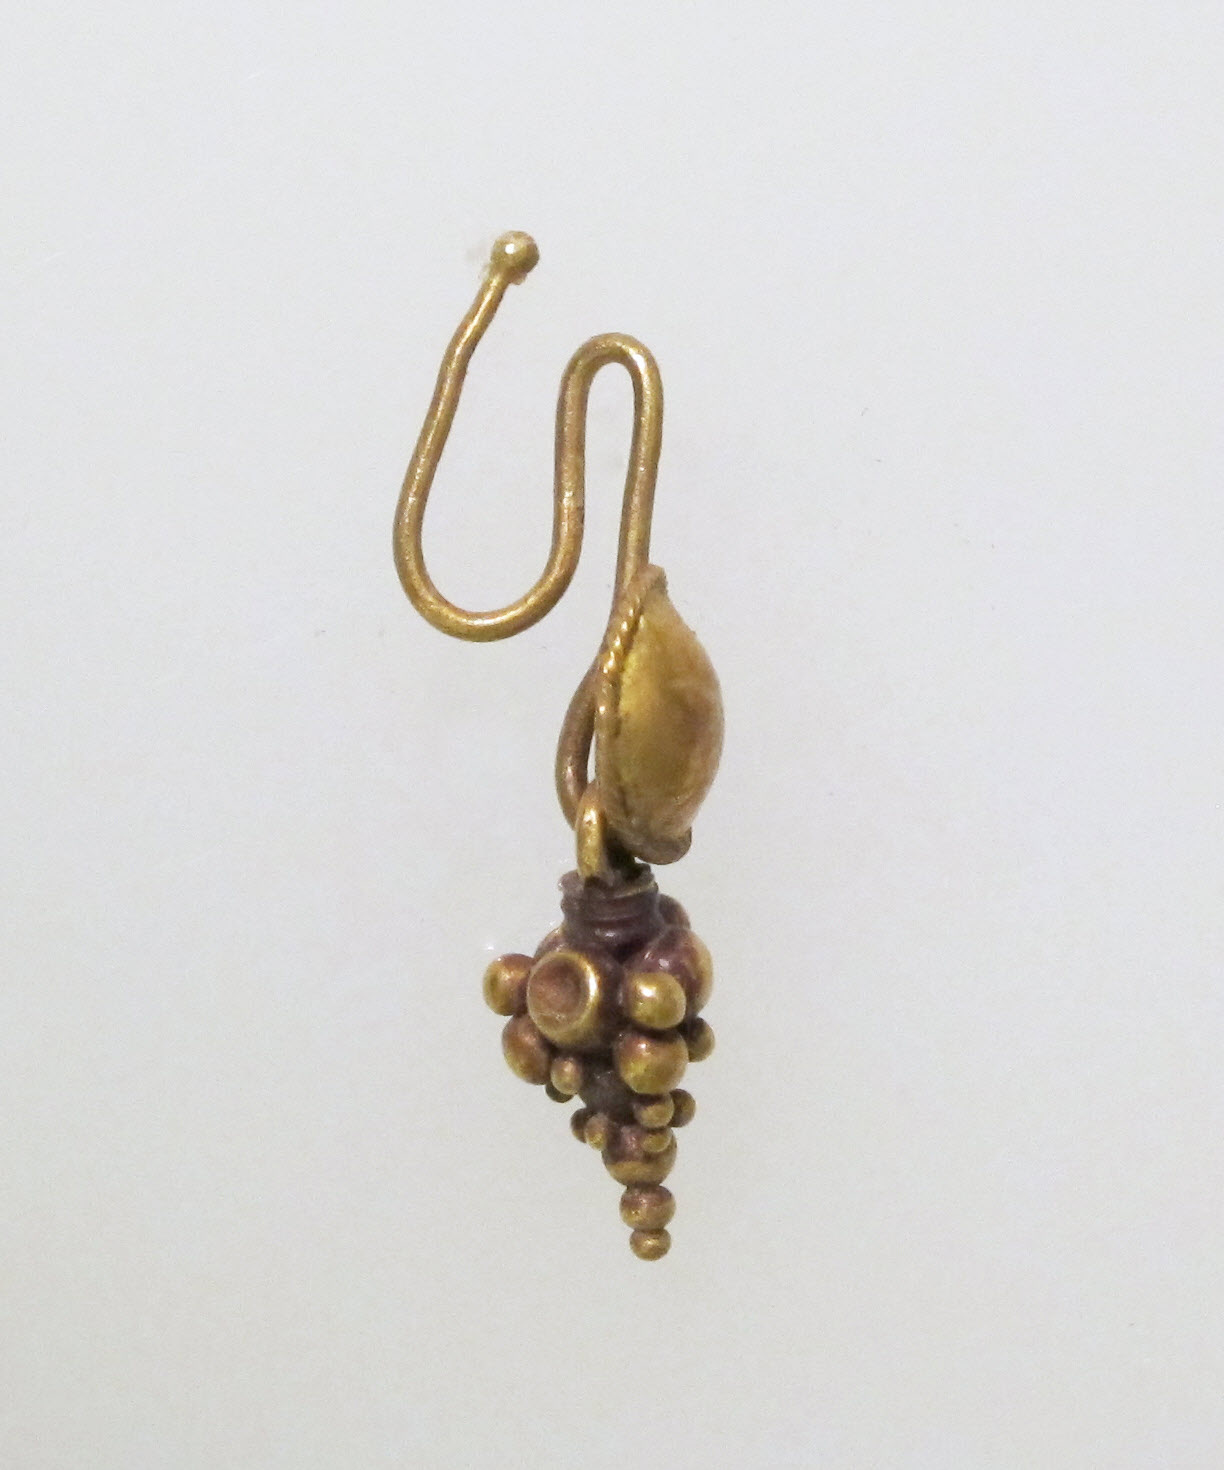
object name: earring hook type with pendant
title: Earring-hook type, with disc and pendant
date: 7000 BCE-330 CE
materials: gold